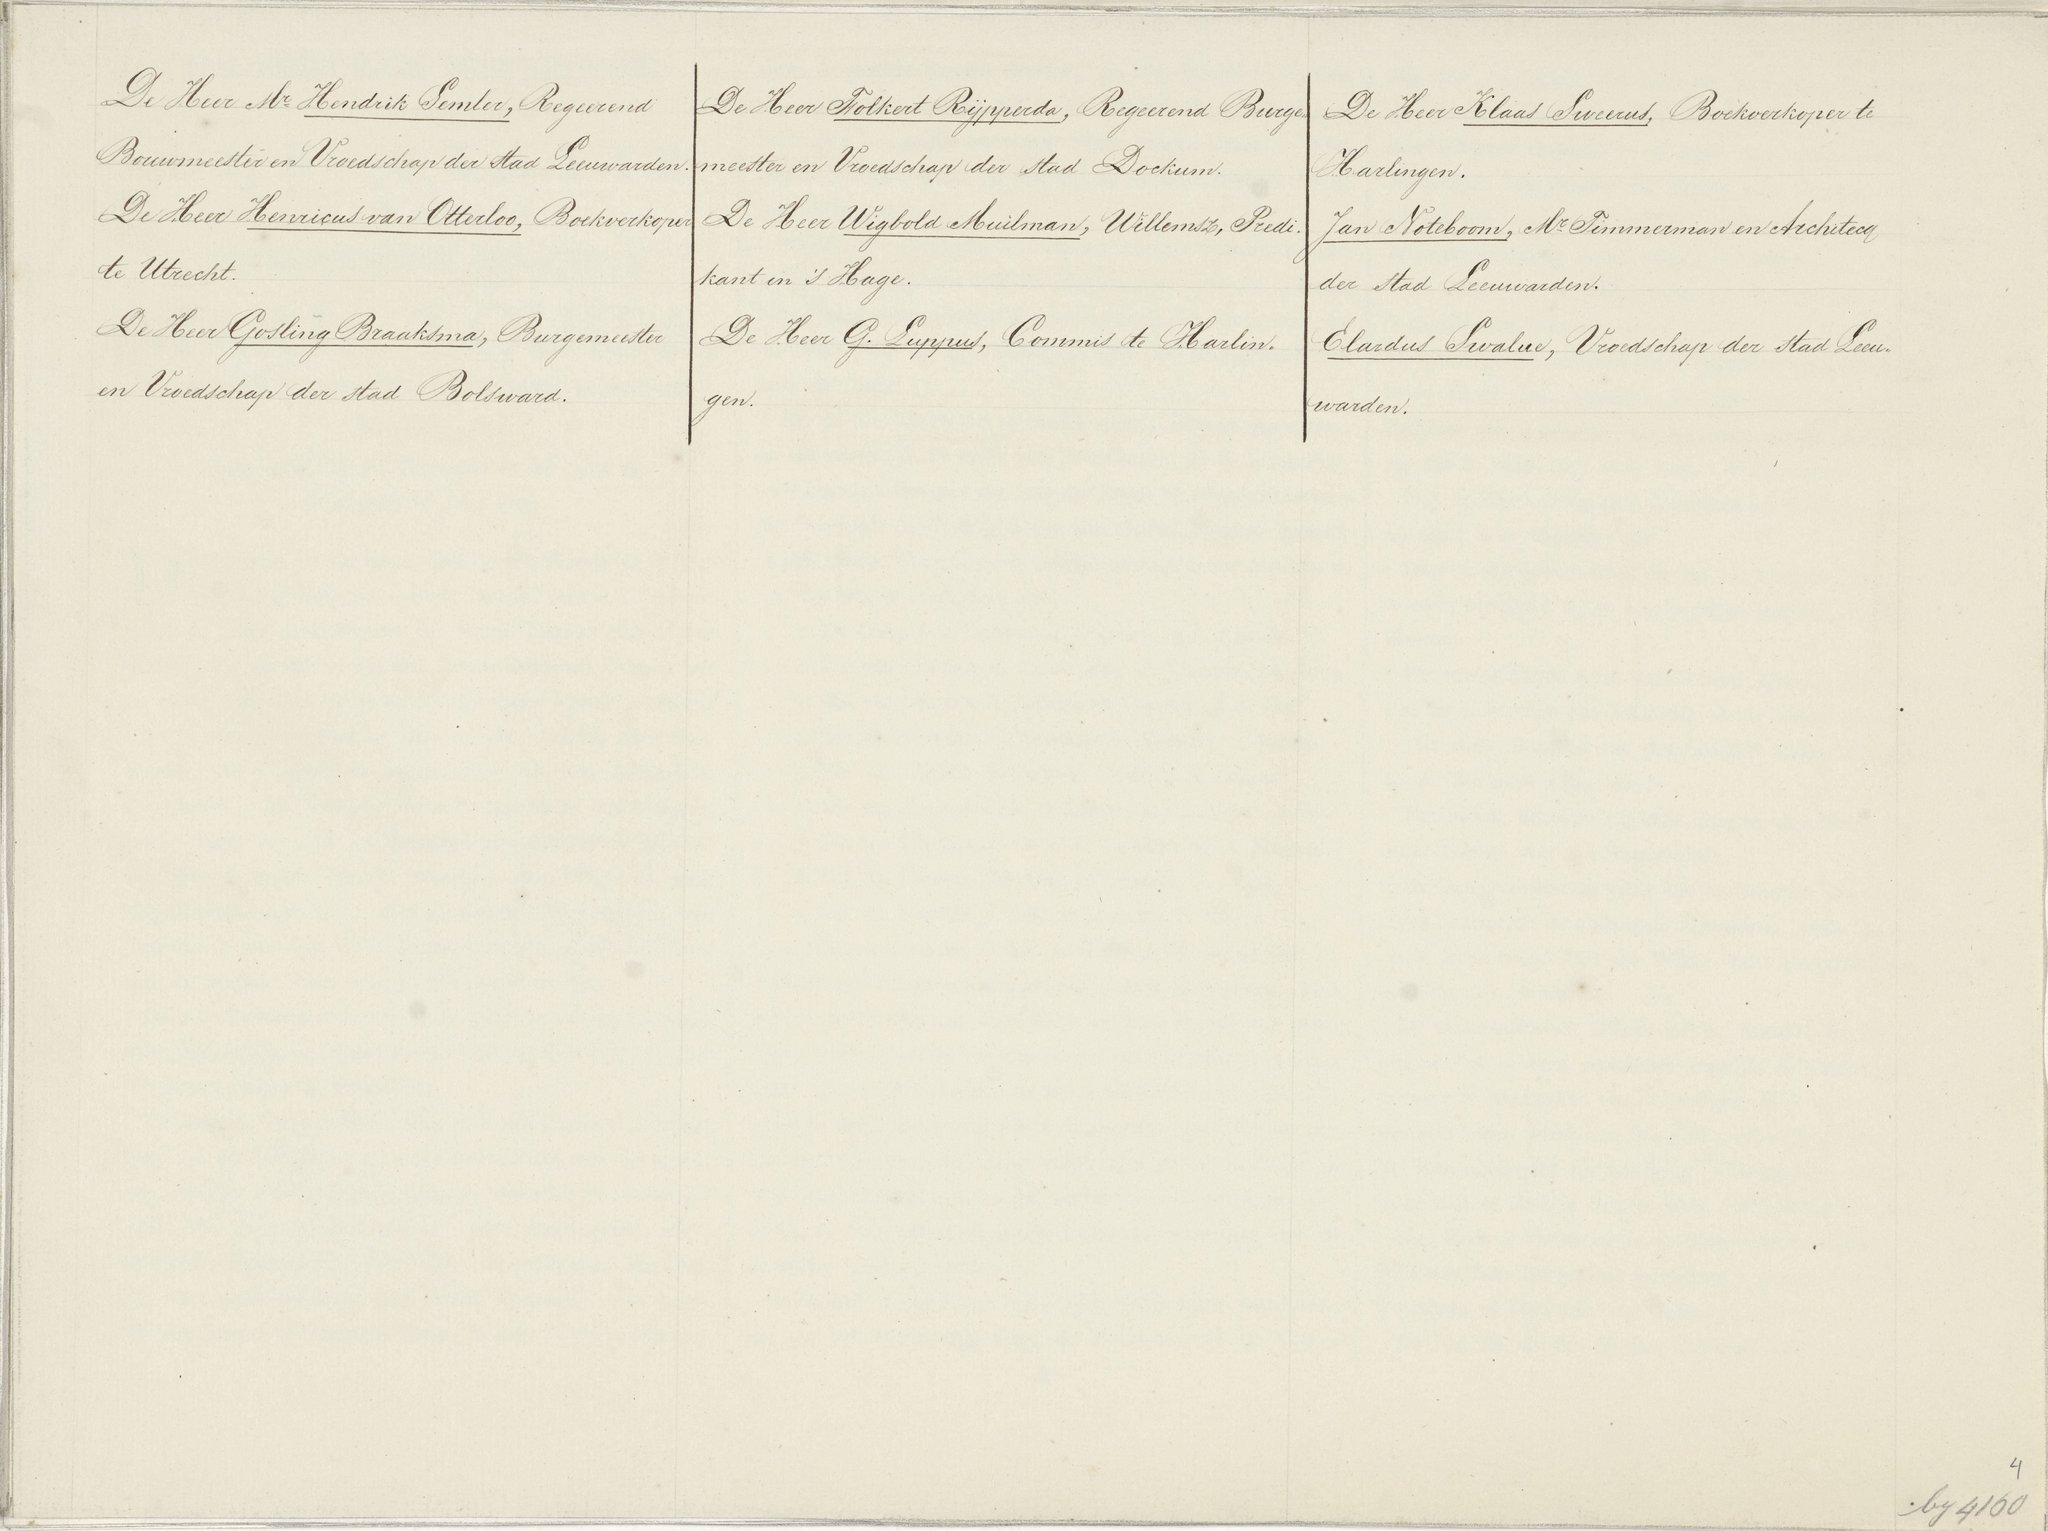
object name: manuscript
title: Lijkstatie van prinses Maria Louise, 1765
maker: Anonymous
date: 1800-1899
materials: paper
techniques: writing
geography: netherlands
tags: kassel, maria louisa van hessen-kassel, leeuwarden, begrafenis van maria louise, prinses van oranje-nassau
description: Handgeschreven blad met het laatste deel van de lijst met namen van de intekenaren op de serie platen van de begrafenis van prinses Maria Louise te Leeuwarden op 13 juni 1765. Waarschijnlijk negentiende-eeuwse afschrift naar de bij dit exemplaar ontbrekende originele gedrukte tekstbladen.